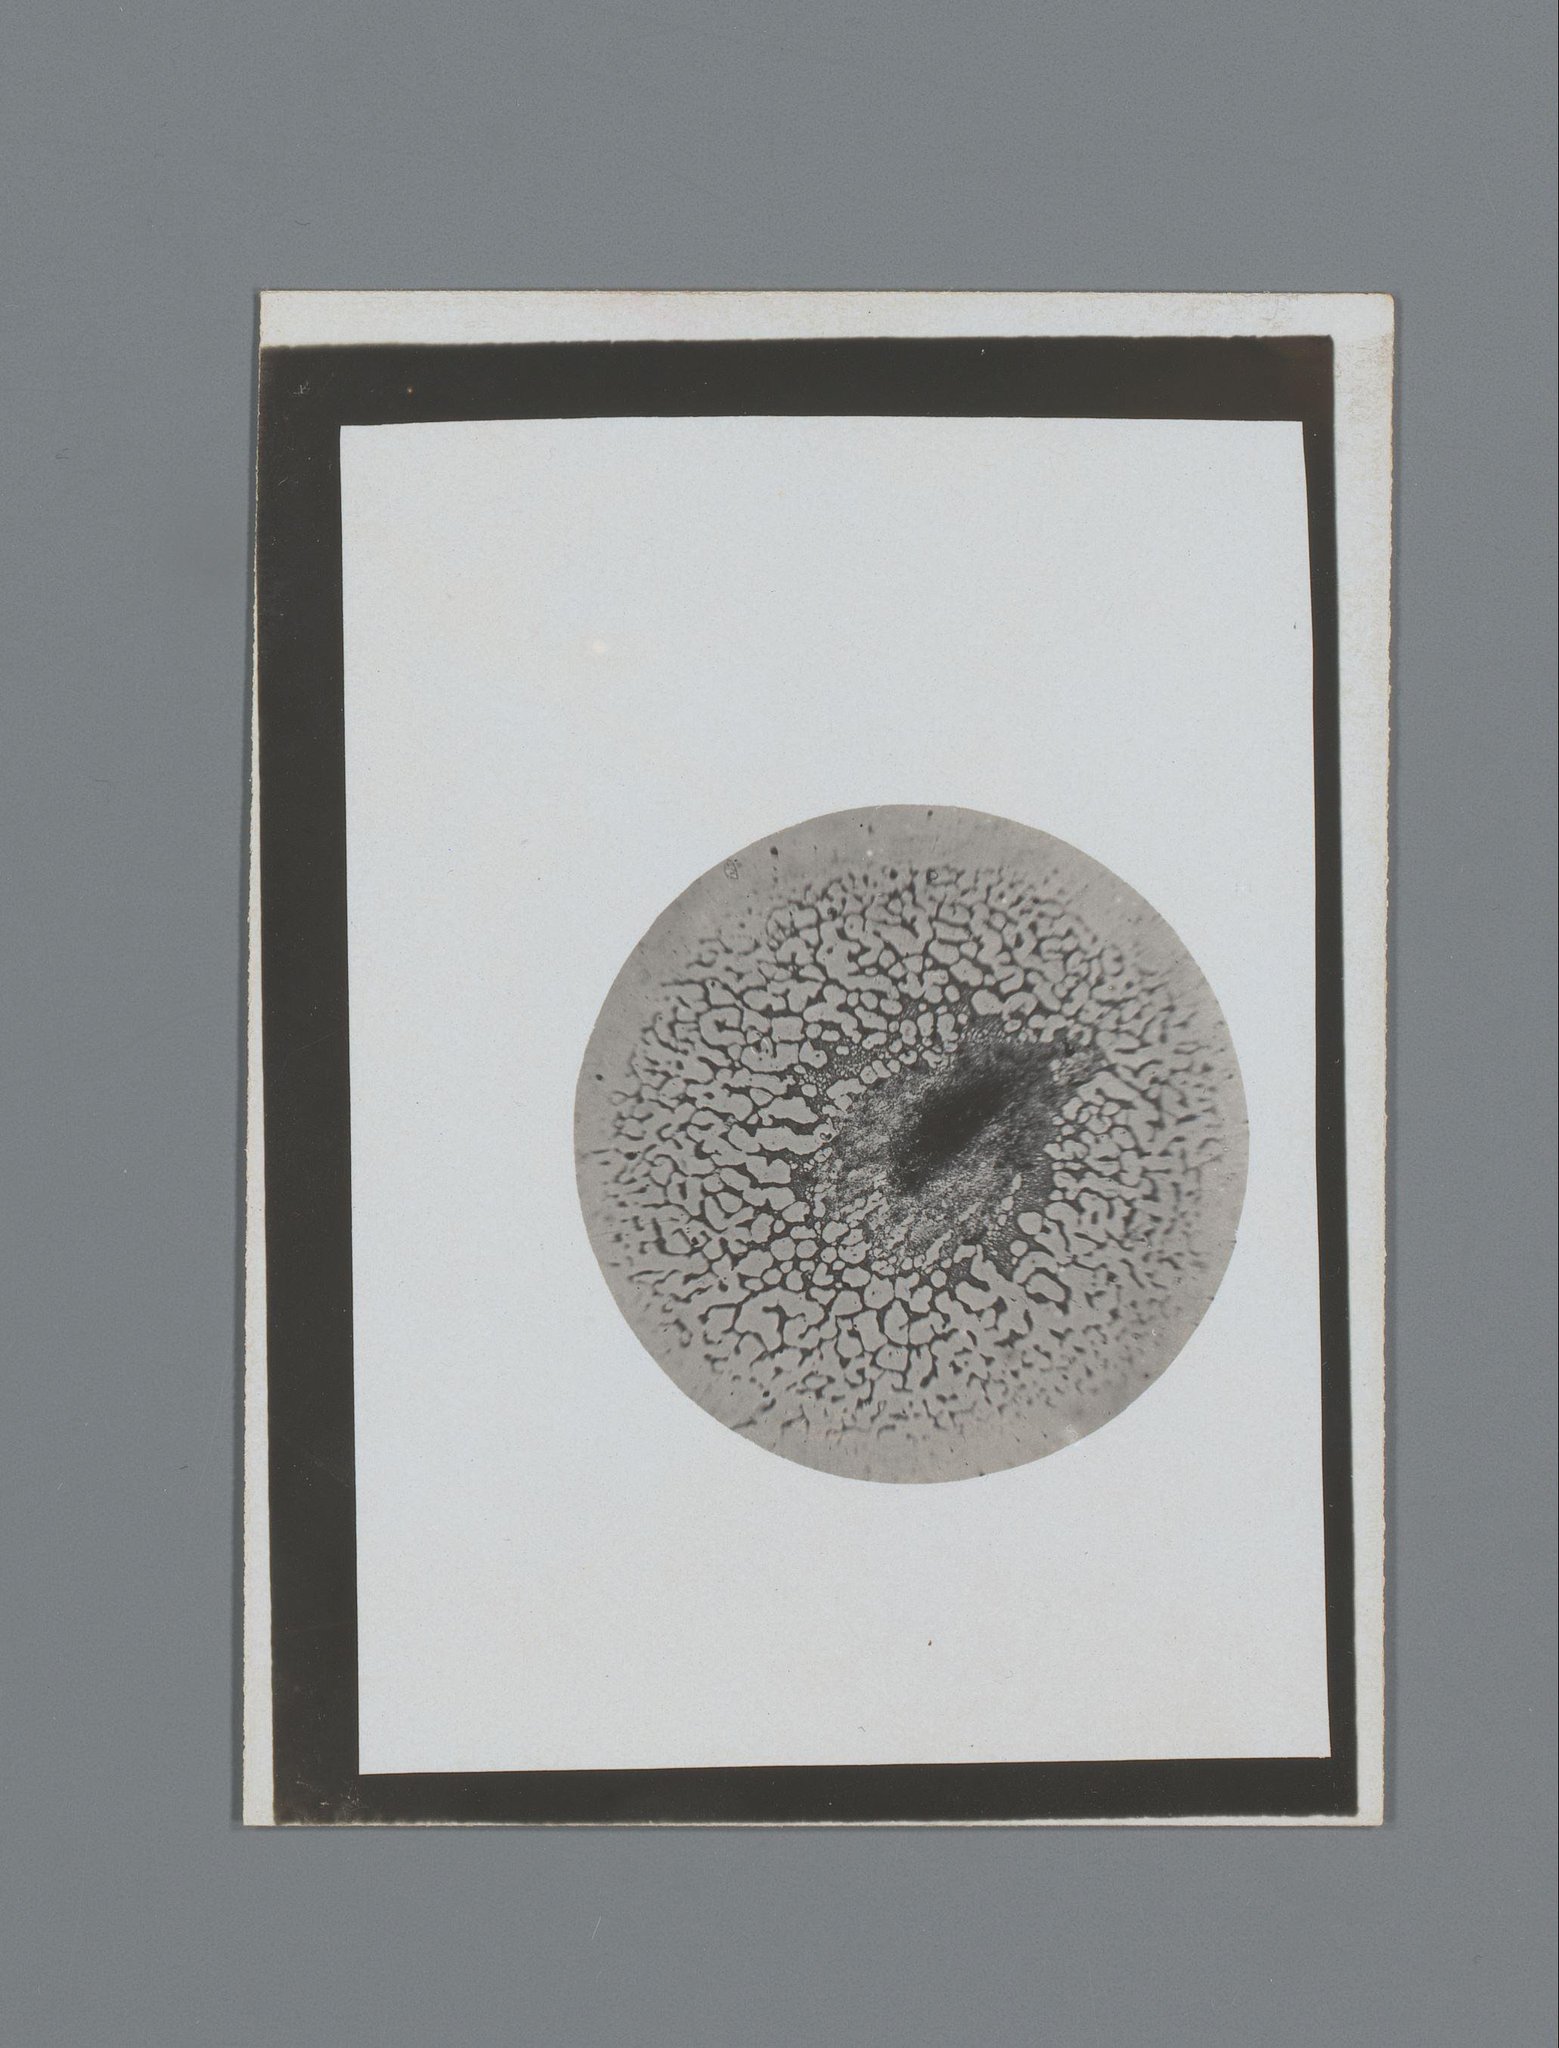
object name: photograph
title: Opname van een microscopisch preparaat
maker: Anonymous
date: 1880-1910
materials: paper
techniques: gelatin silver print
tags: unicellular animals, bacteria, bacilli